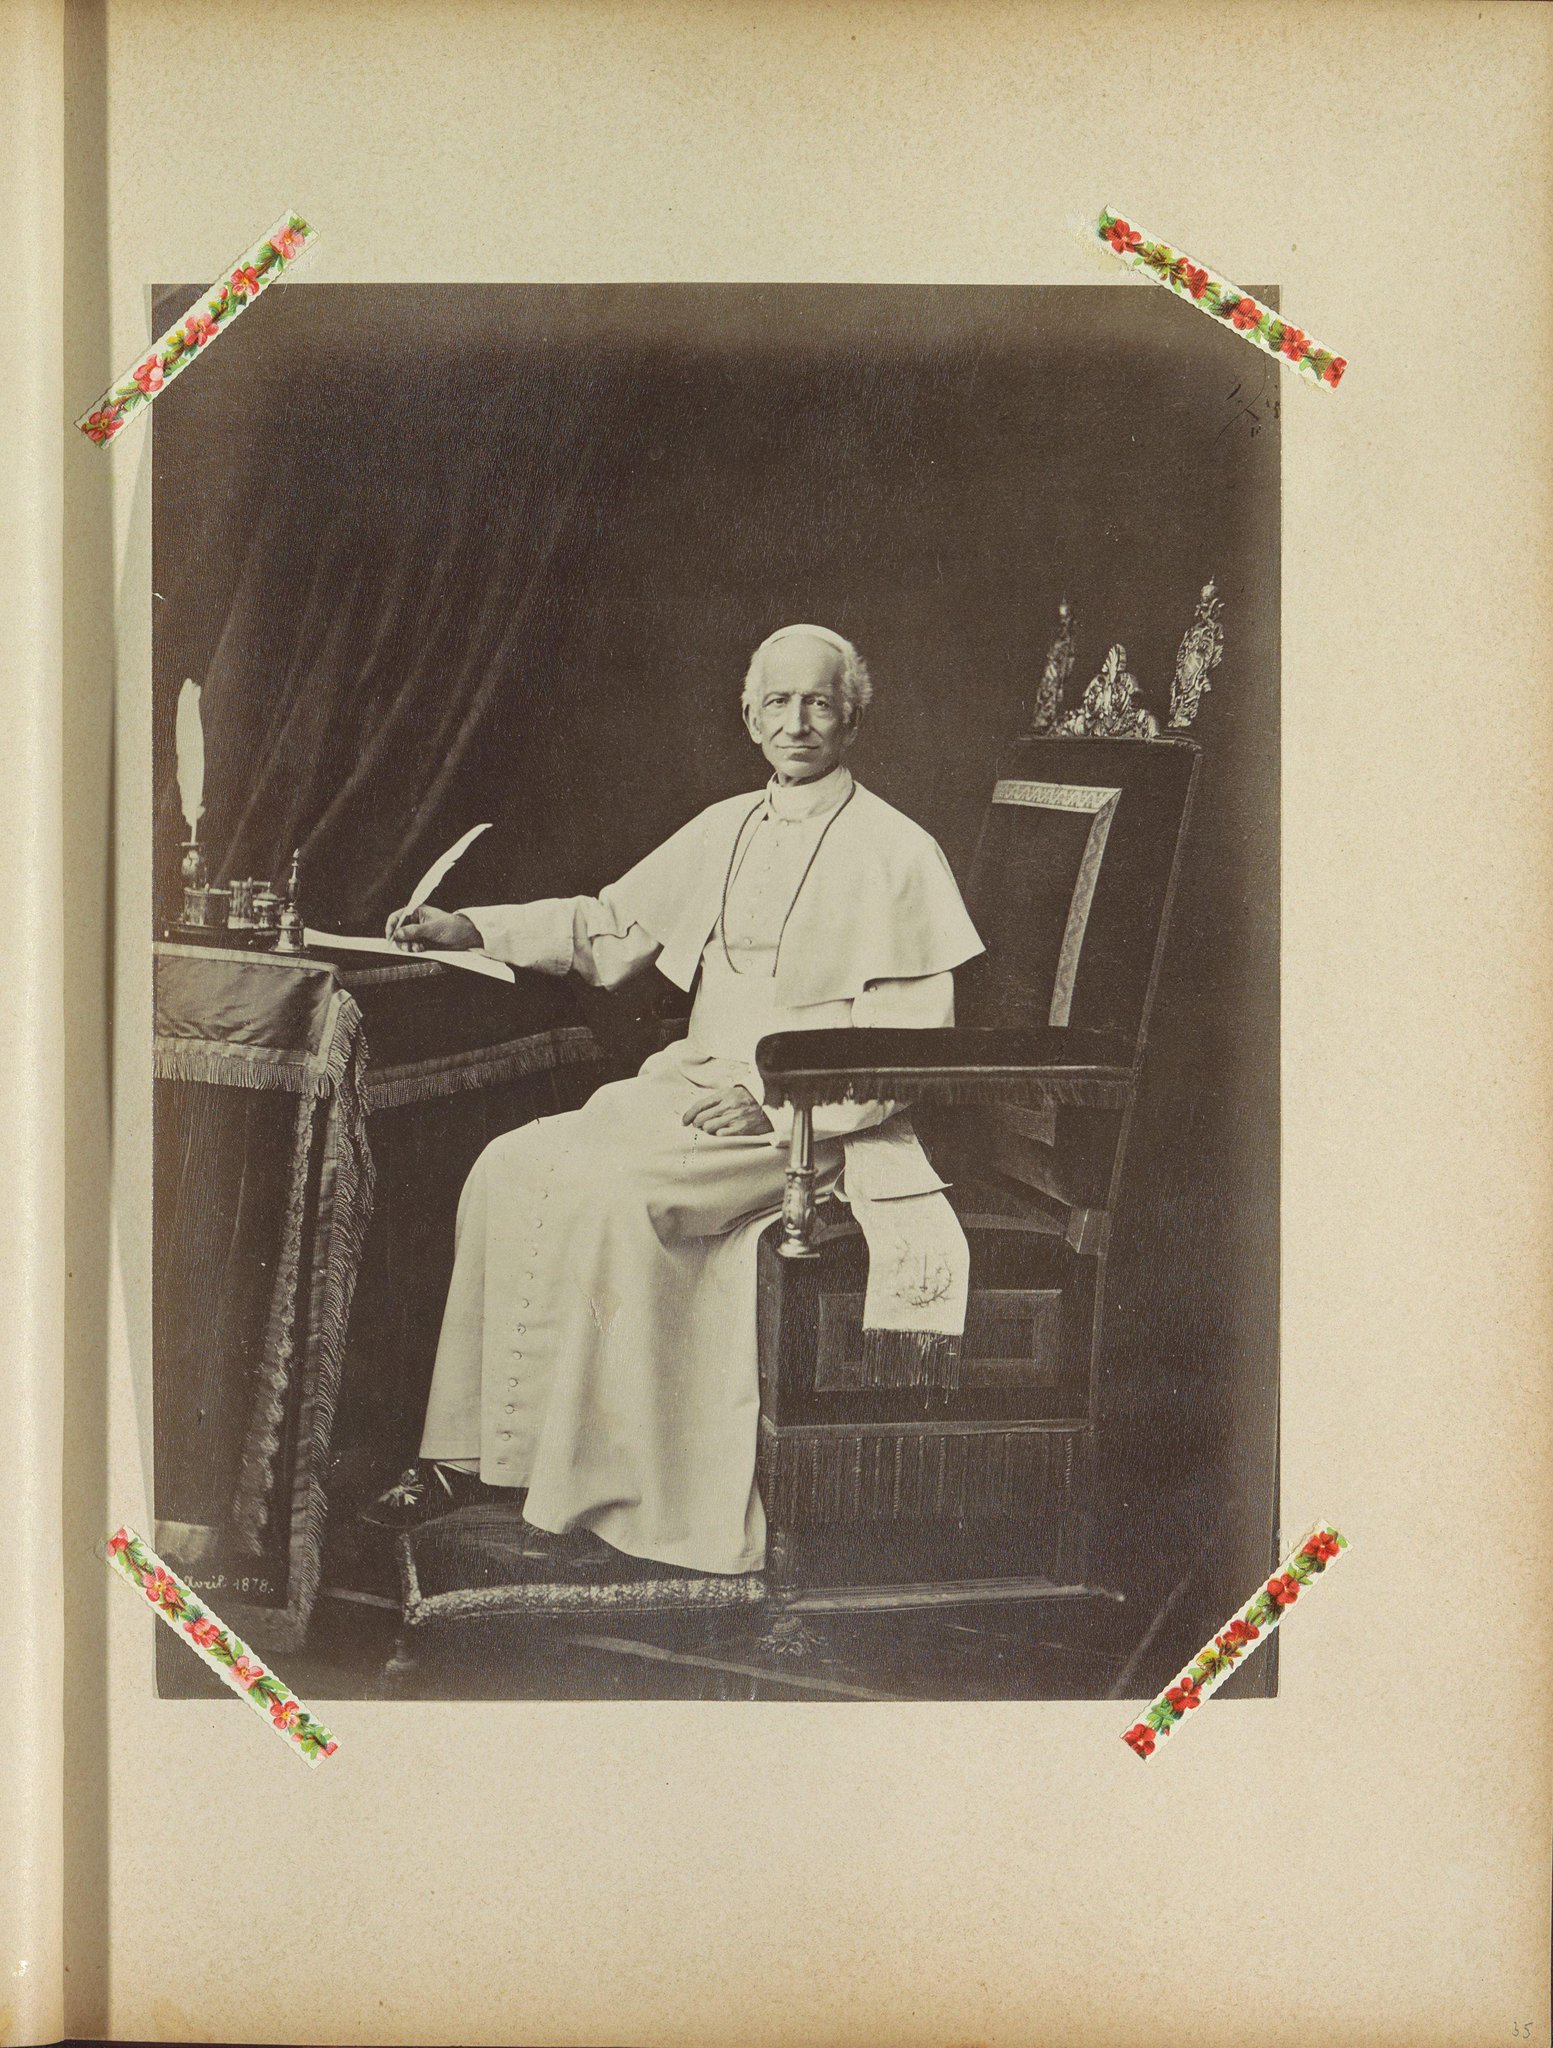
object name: photograph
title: Portret van paus Leo XIII, zittend, van opzij gezien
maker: Anonymous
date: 1804-1878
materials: photographic support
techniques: albumen print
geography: italy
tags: leo xiii, pope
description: Onderdeel van Fotoalbum met opnames van bezienswaardigheden in Italiaanse steden en van kunstwerken.